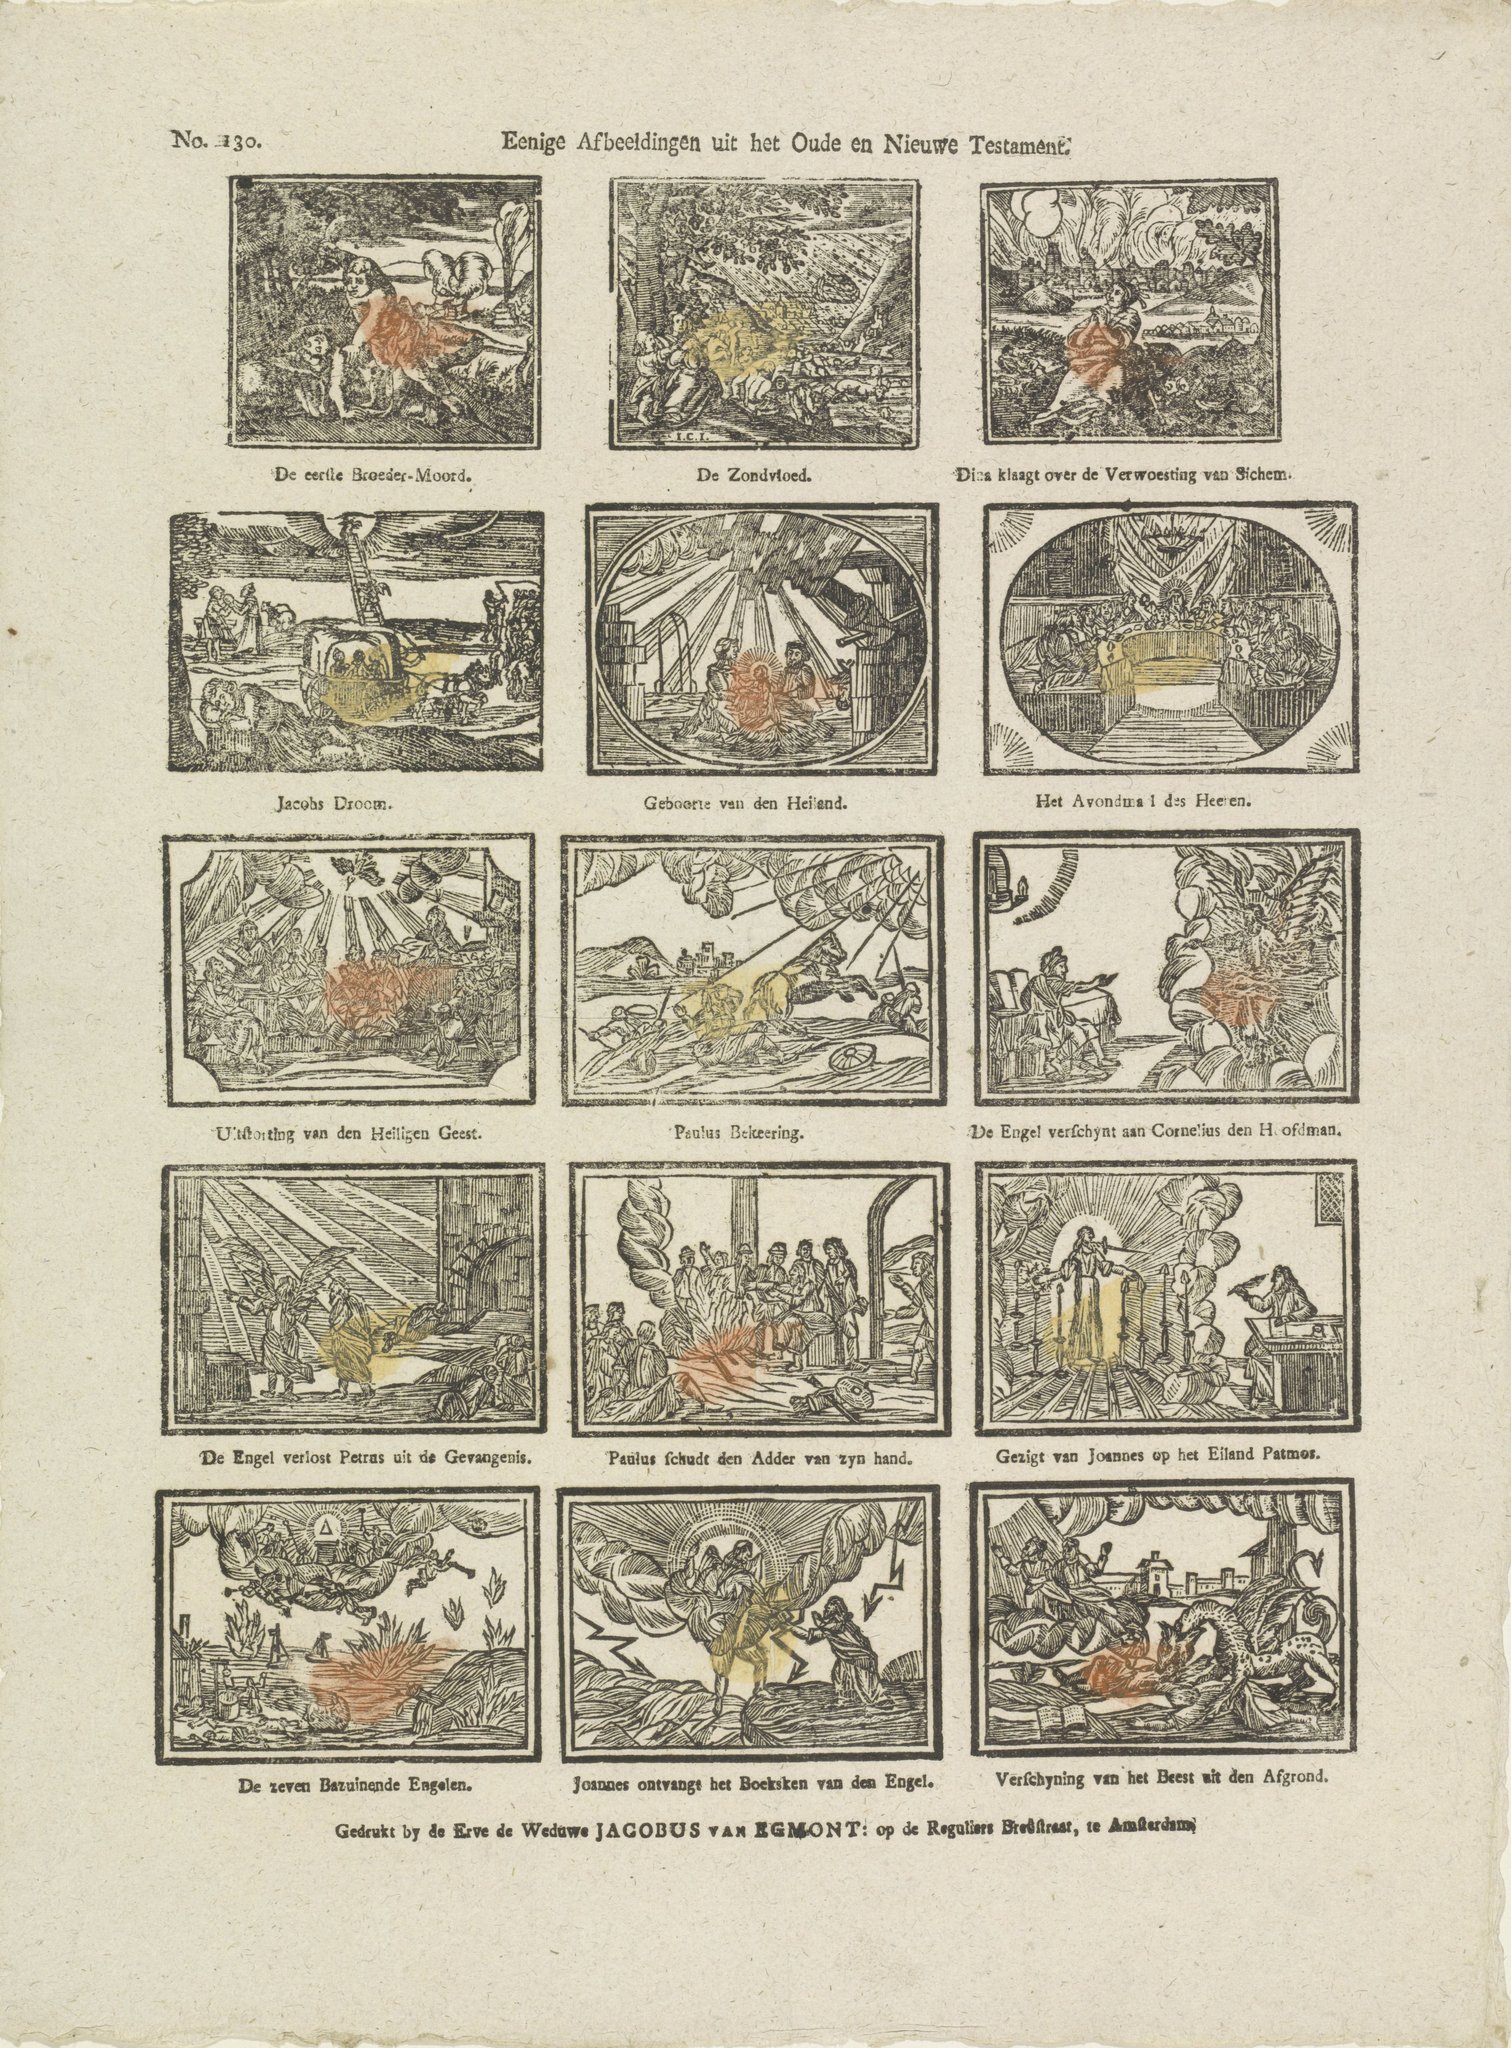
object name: popular print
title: Eenige afbeeldingen uit het Oude en Nieuwe Testament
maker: Anonymous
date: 1761-1804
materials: paper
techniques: colour, letterpress printing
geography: amsterdam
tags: new testament, old testament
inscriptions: collector's mark: Lugt 2760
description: Blad met 15 voorstellingen van verhalen uit het Oude en het Nieuwe Testament, waaronder Jakobs ladder, de geboorte van Christus en Johannes op het eiland Patmos. Onder elke voorstelling een onderschrift. Genummerd linksboven: No. 130.